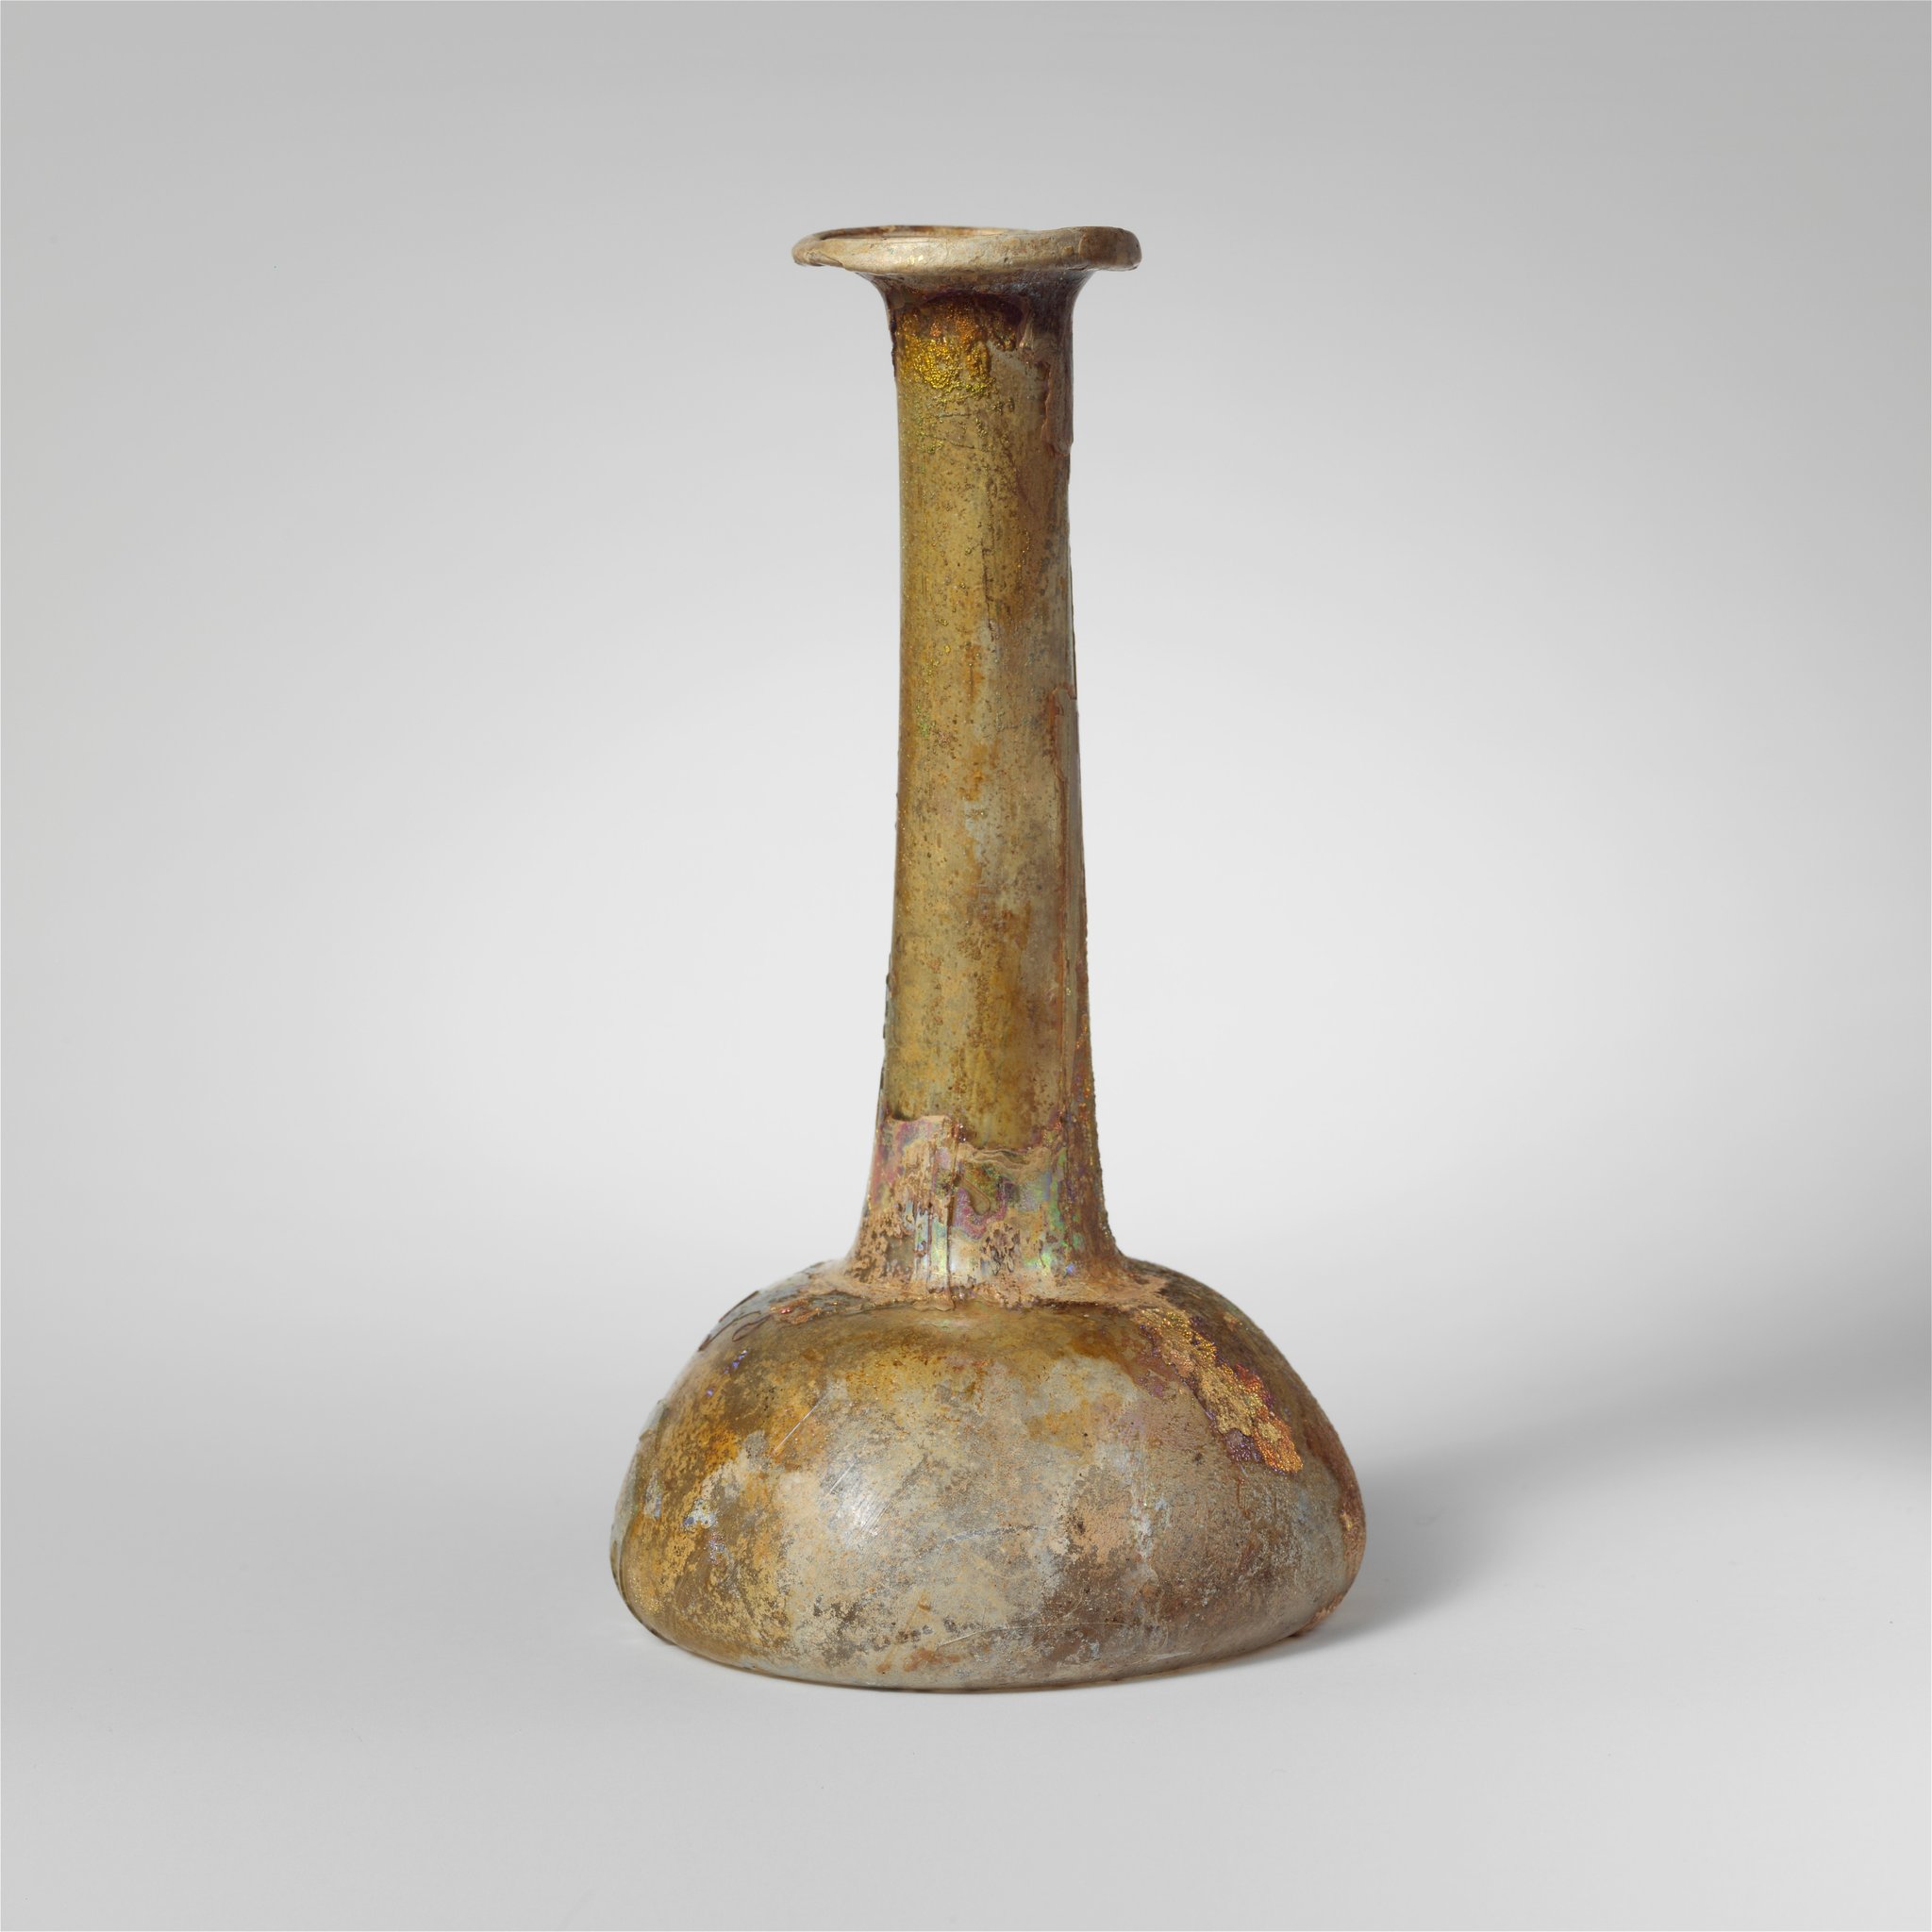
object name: perfume bottle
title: Glass perfume bottle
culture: roman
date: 101-300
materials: glass